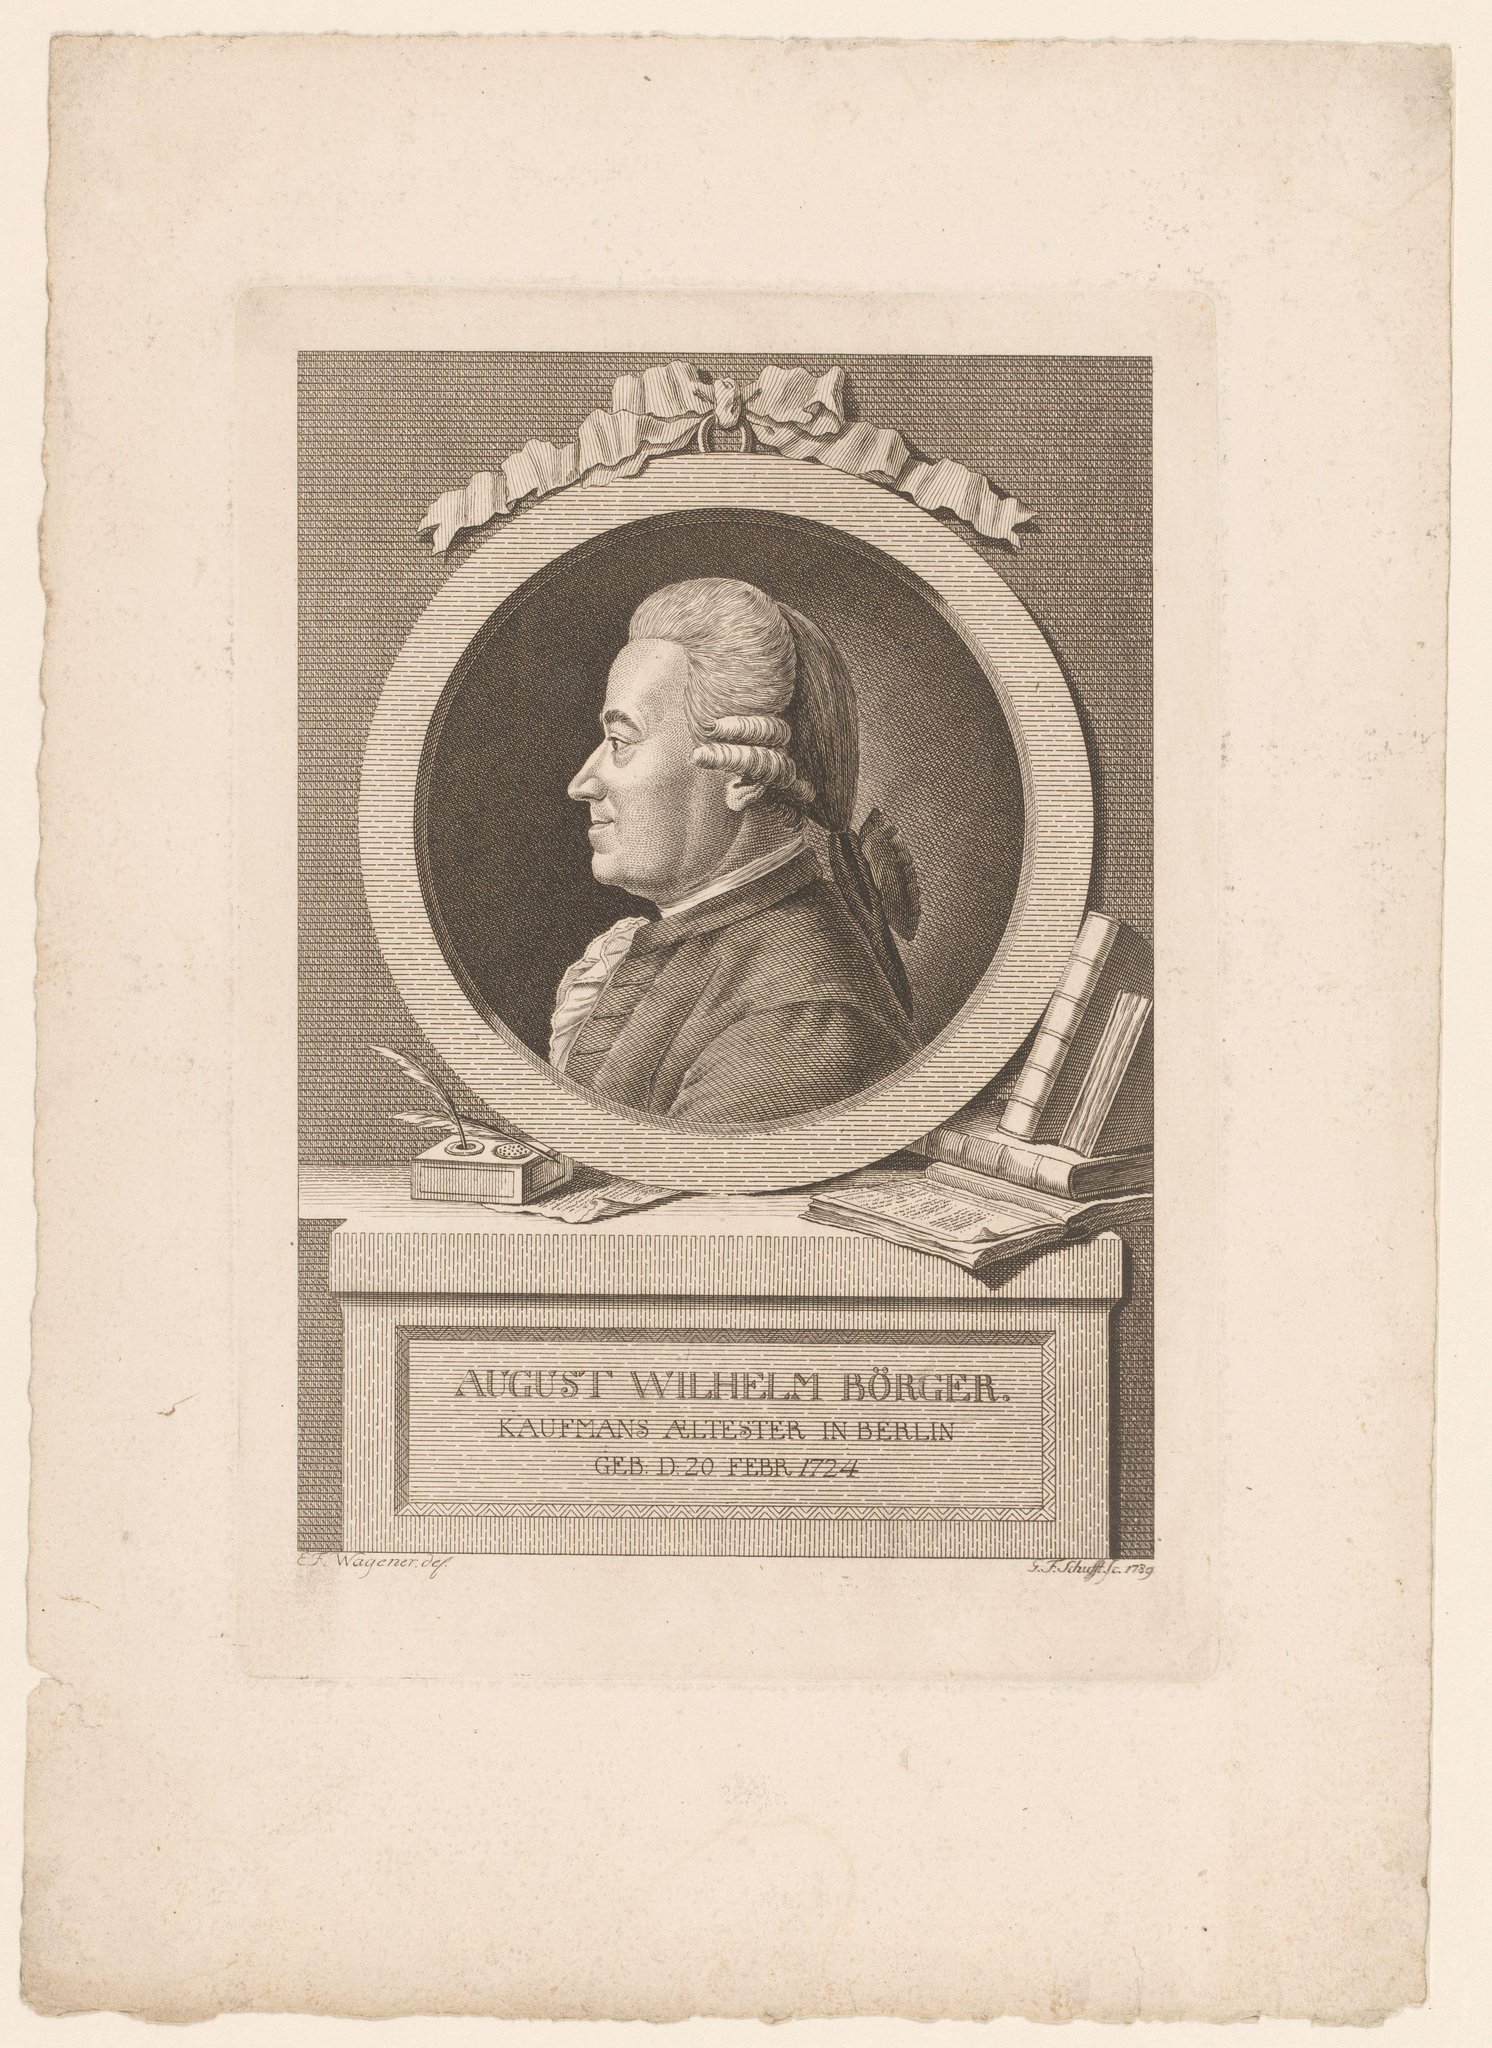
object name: print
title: Portret van August Wilhelm Börger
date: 1789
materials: paper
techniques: engraving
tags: berlin, historical persons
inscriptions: collector's mark: Lugt 2228